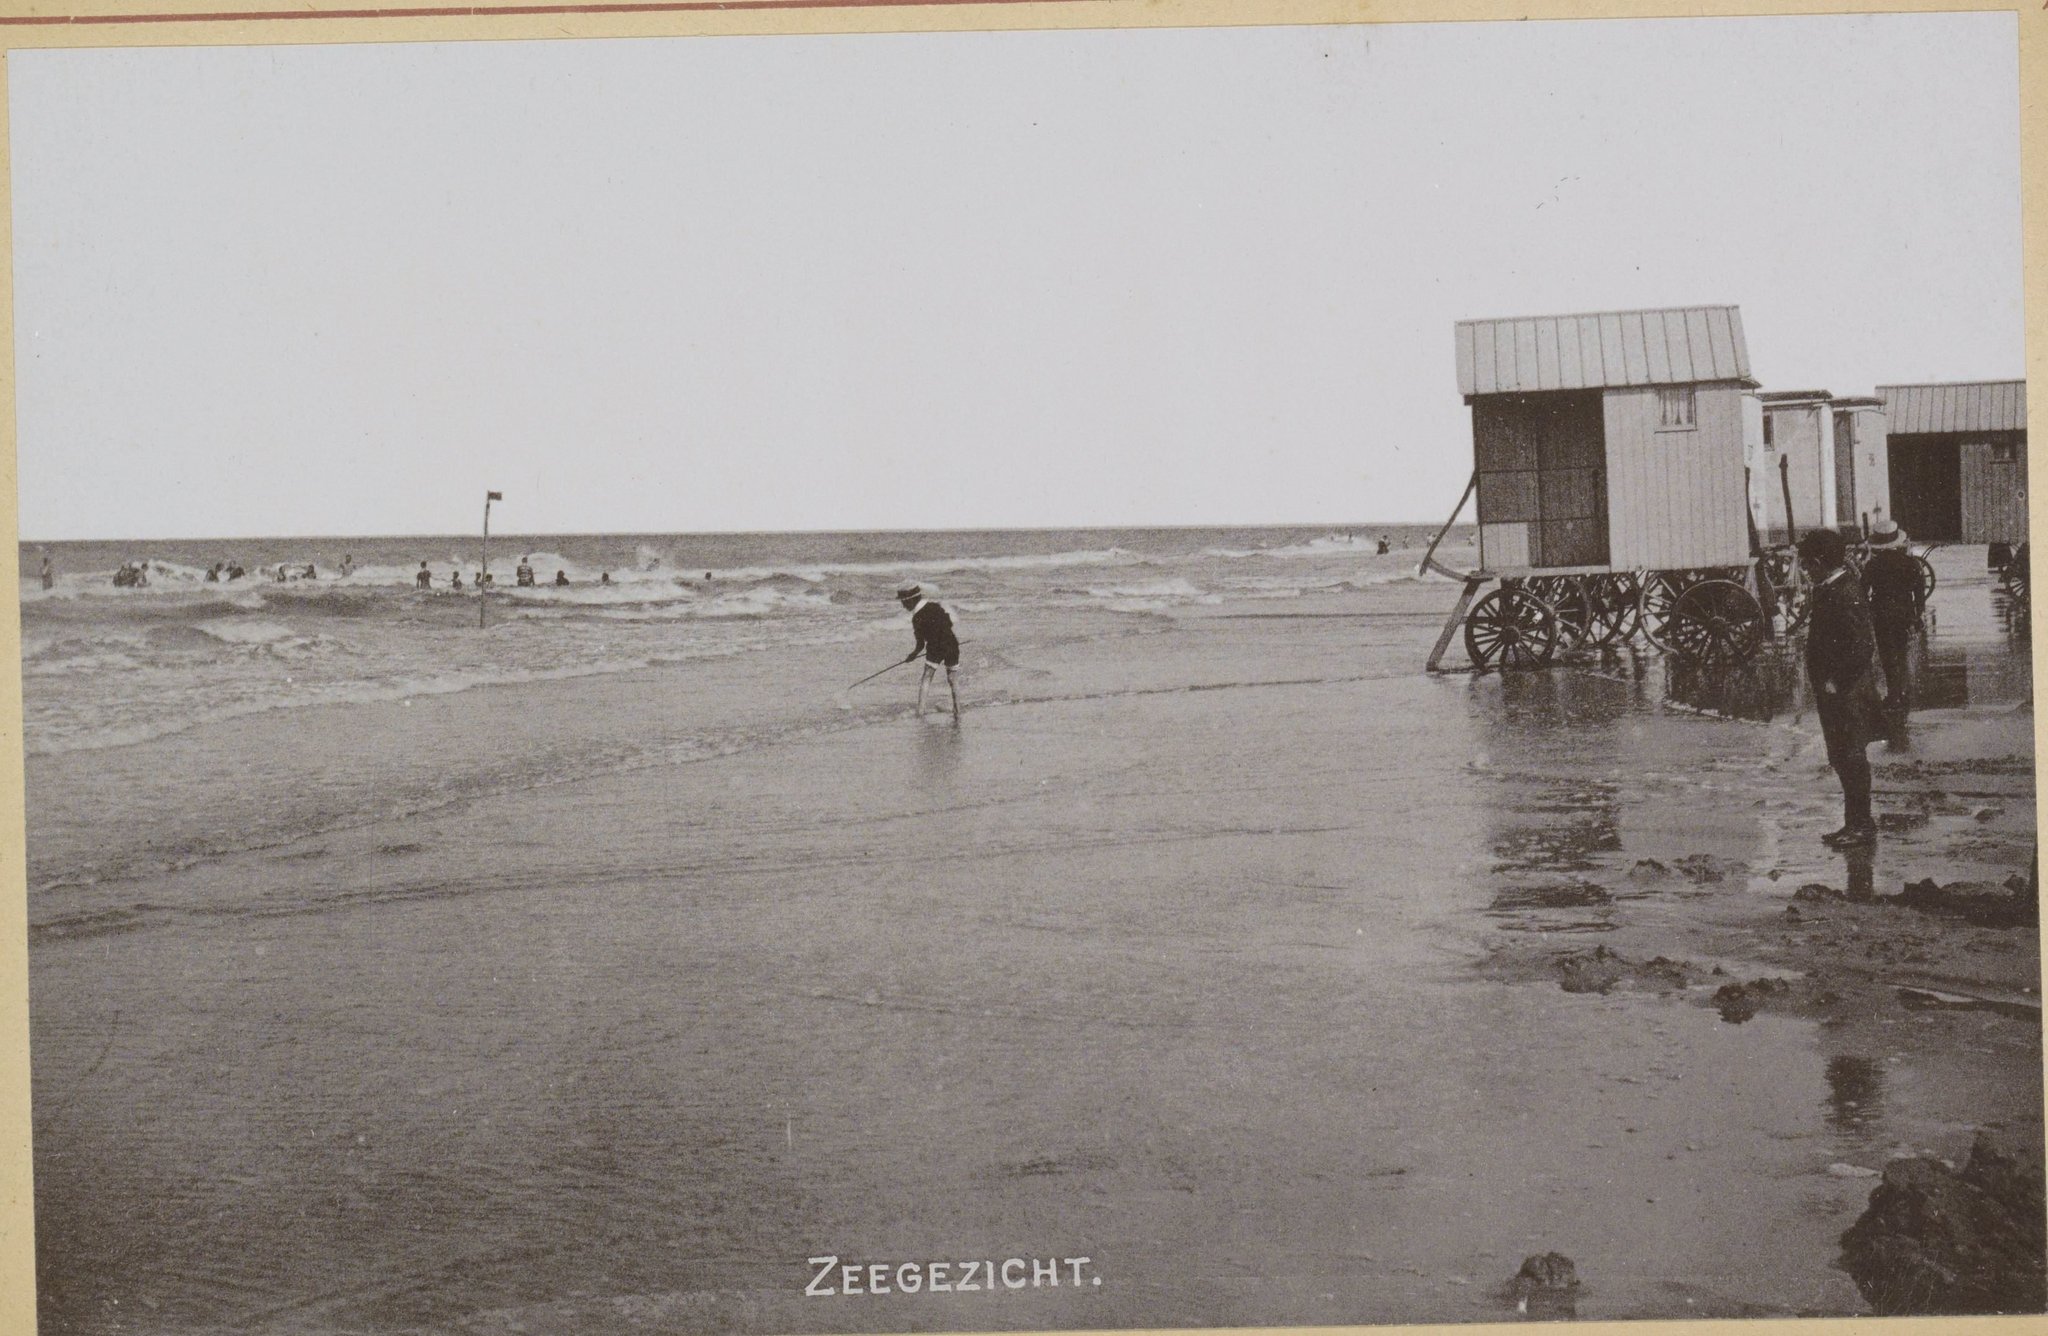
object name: cabinet photograph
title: Zeegezicht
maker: Anonymous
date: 1890-1910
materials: cardboard, paper, ink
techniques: photograph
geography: scheveningen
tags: beach (as place of recreation)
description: Onderdeel van Leporelloalbum met opnames van Scheveningen.